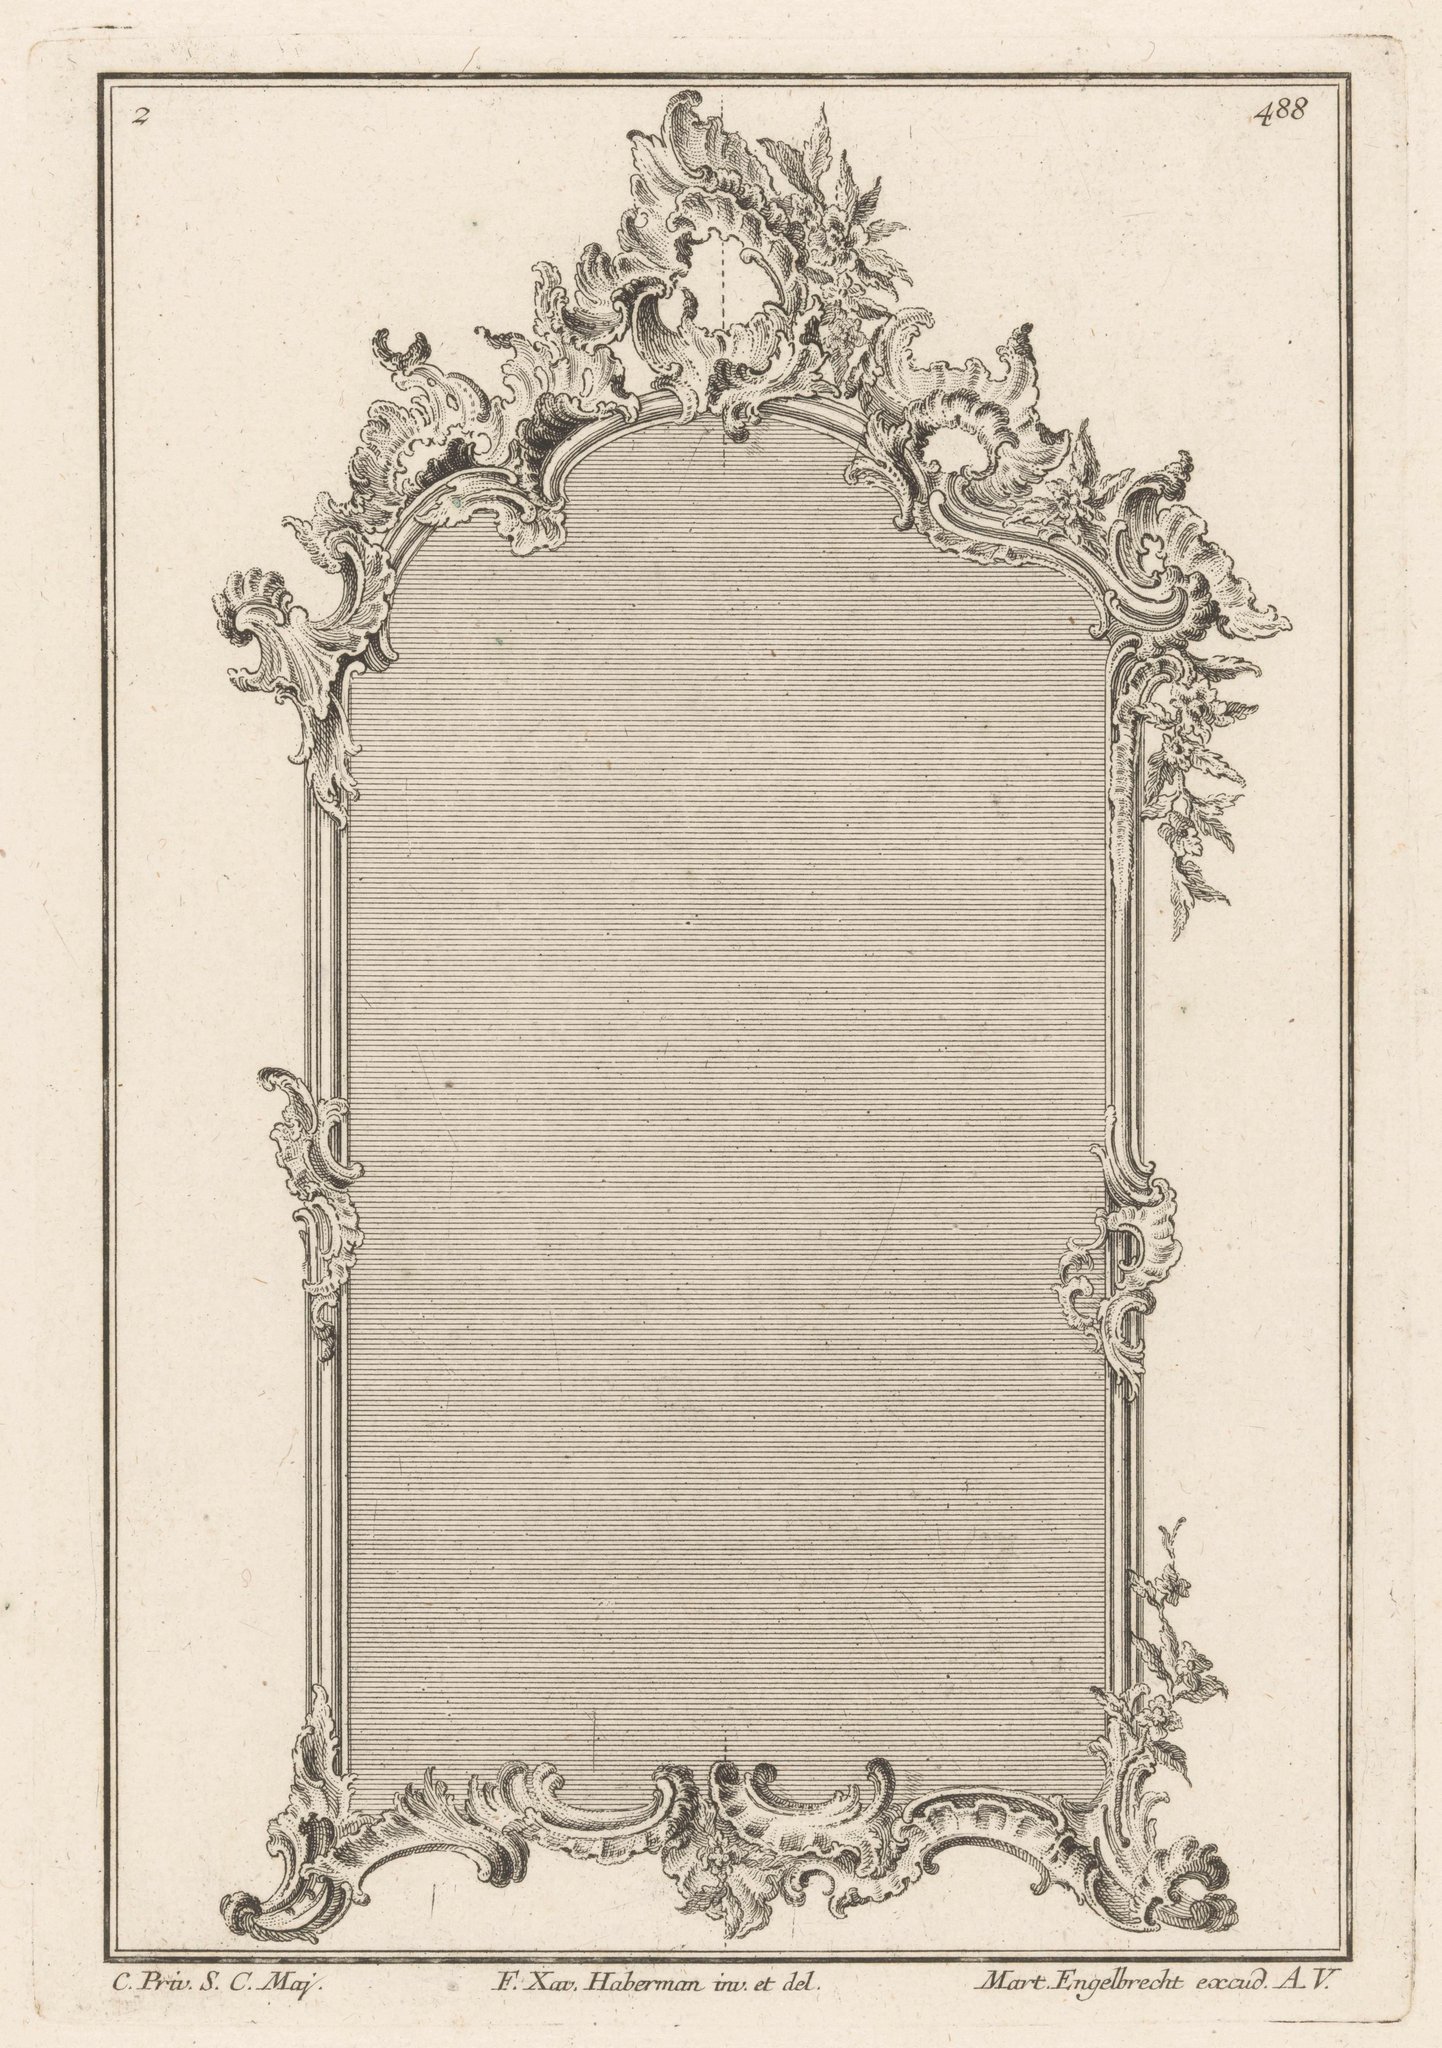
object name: print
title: Spiegel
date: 1731-1756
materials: paper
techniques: engraving, etching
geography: augsburg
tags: mirror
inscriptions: collector's mark: Lugt 2228, collector's mark: Lugt 2760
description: Spiegellijst met rocaille ornamenten. Prentnummer 488, uitgeversnummer 108.